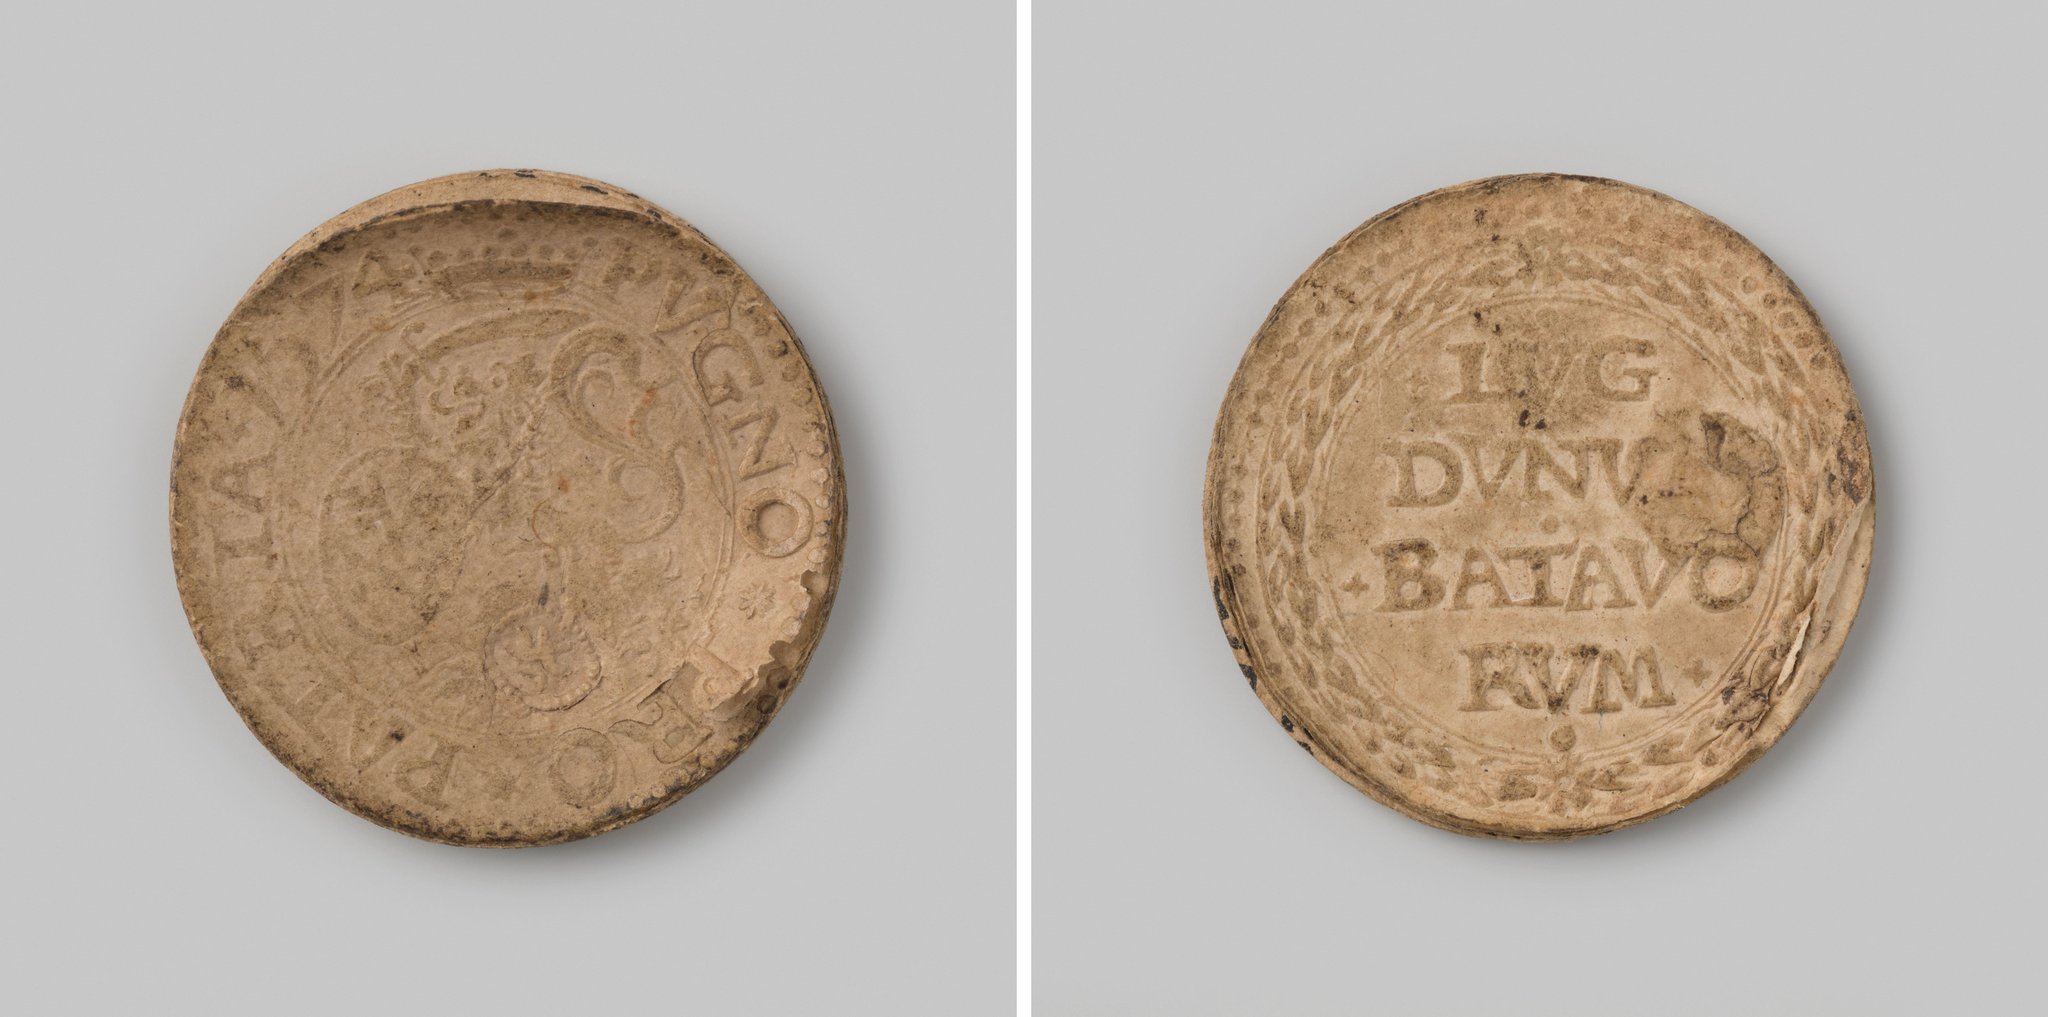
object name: siege coin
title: Stad Leiden, noodmunt van 1/4 of oord gulden, 1574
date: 1574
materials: paper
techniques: striking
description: Papieren noodmunt, vervaardigd uit op elkaar gelijmde, maar inmiddels losse, bladen papier, waaruit een rond muntplaatje is geslagen. Voorzijde: een op een stuk grond staande, klimmende Hollandse leeuw, met in de rechter klauw een kromzwaard en in de linker een ovaal schild met het wapen van Leiden. Boven de leeuw in het omschrift een kroon. Aan het eind van het omschrift het jaartal: jaartal 1574. Tussen de achterpoten van de leeuw een instempeling: een Hollandse leeuw binnen een ovale parelrand (om de echtheid te garanderen). Keerzijde: binnen een lauwerkrans een vierregelig opschrift: LVG/DVNVM/BATAVO/RVM.